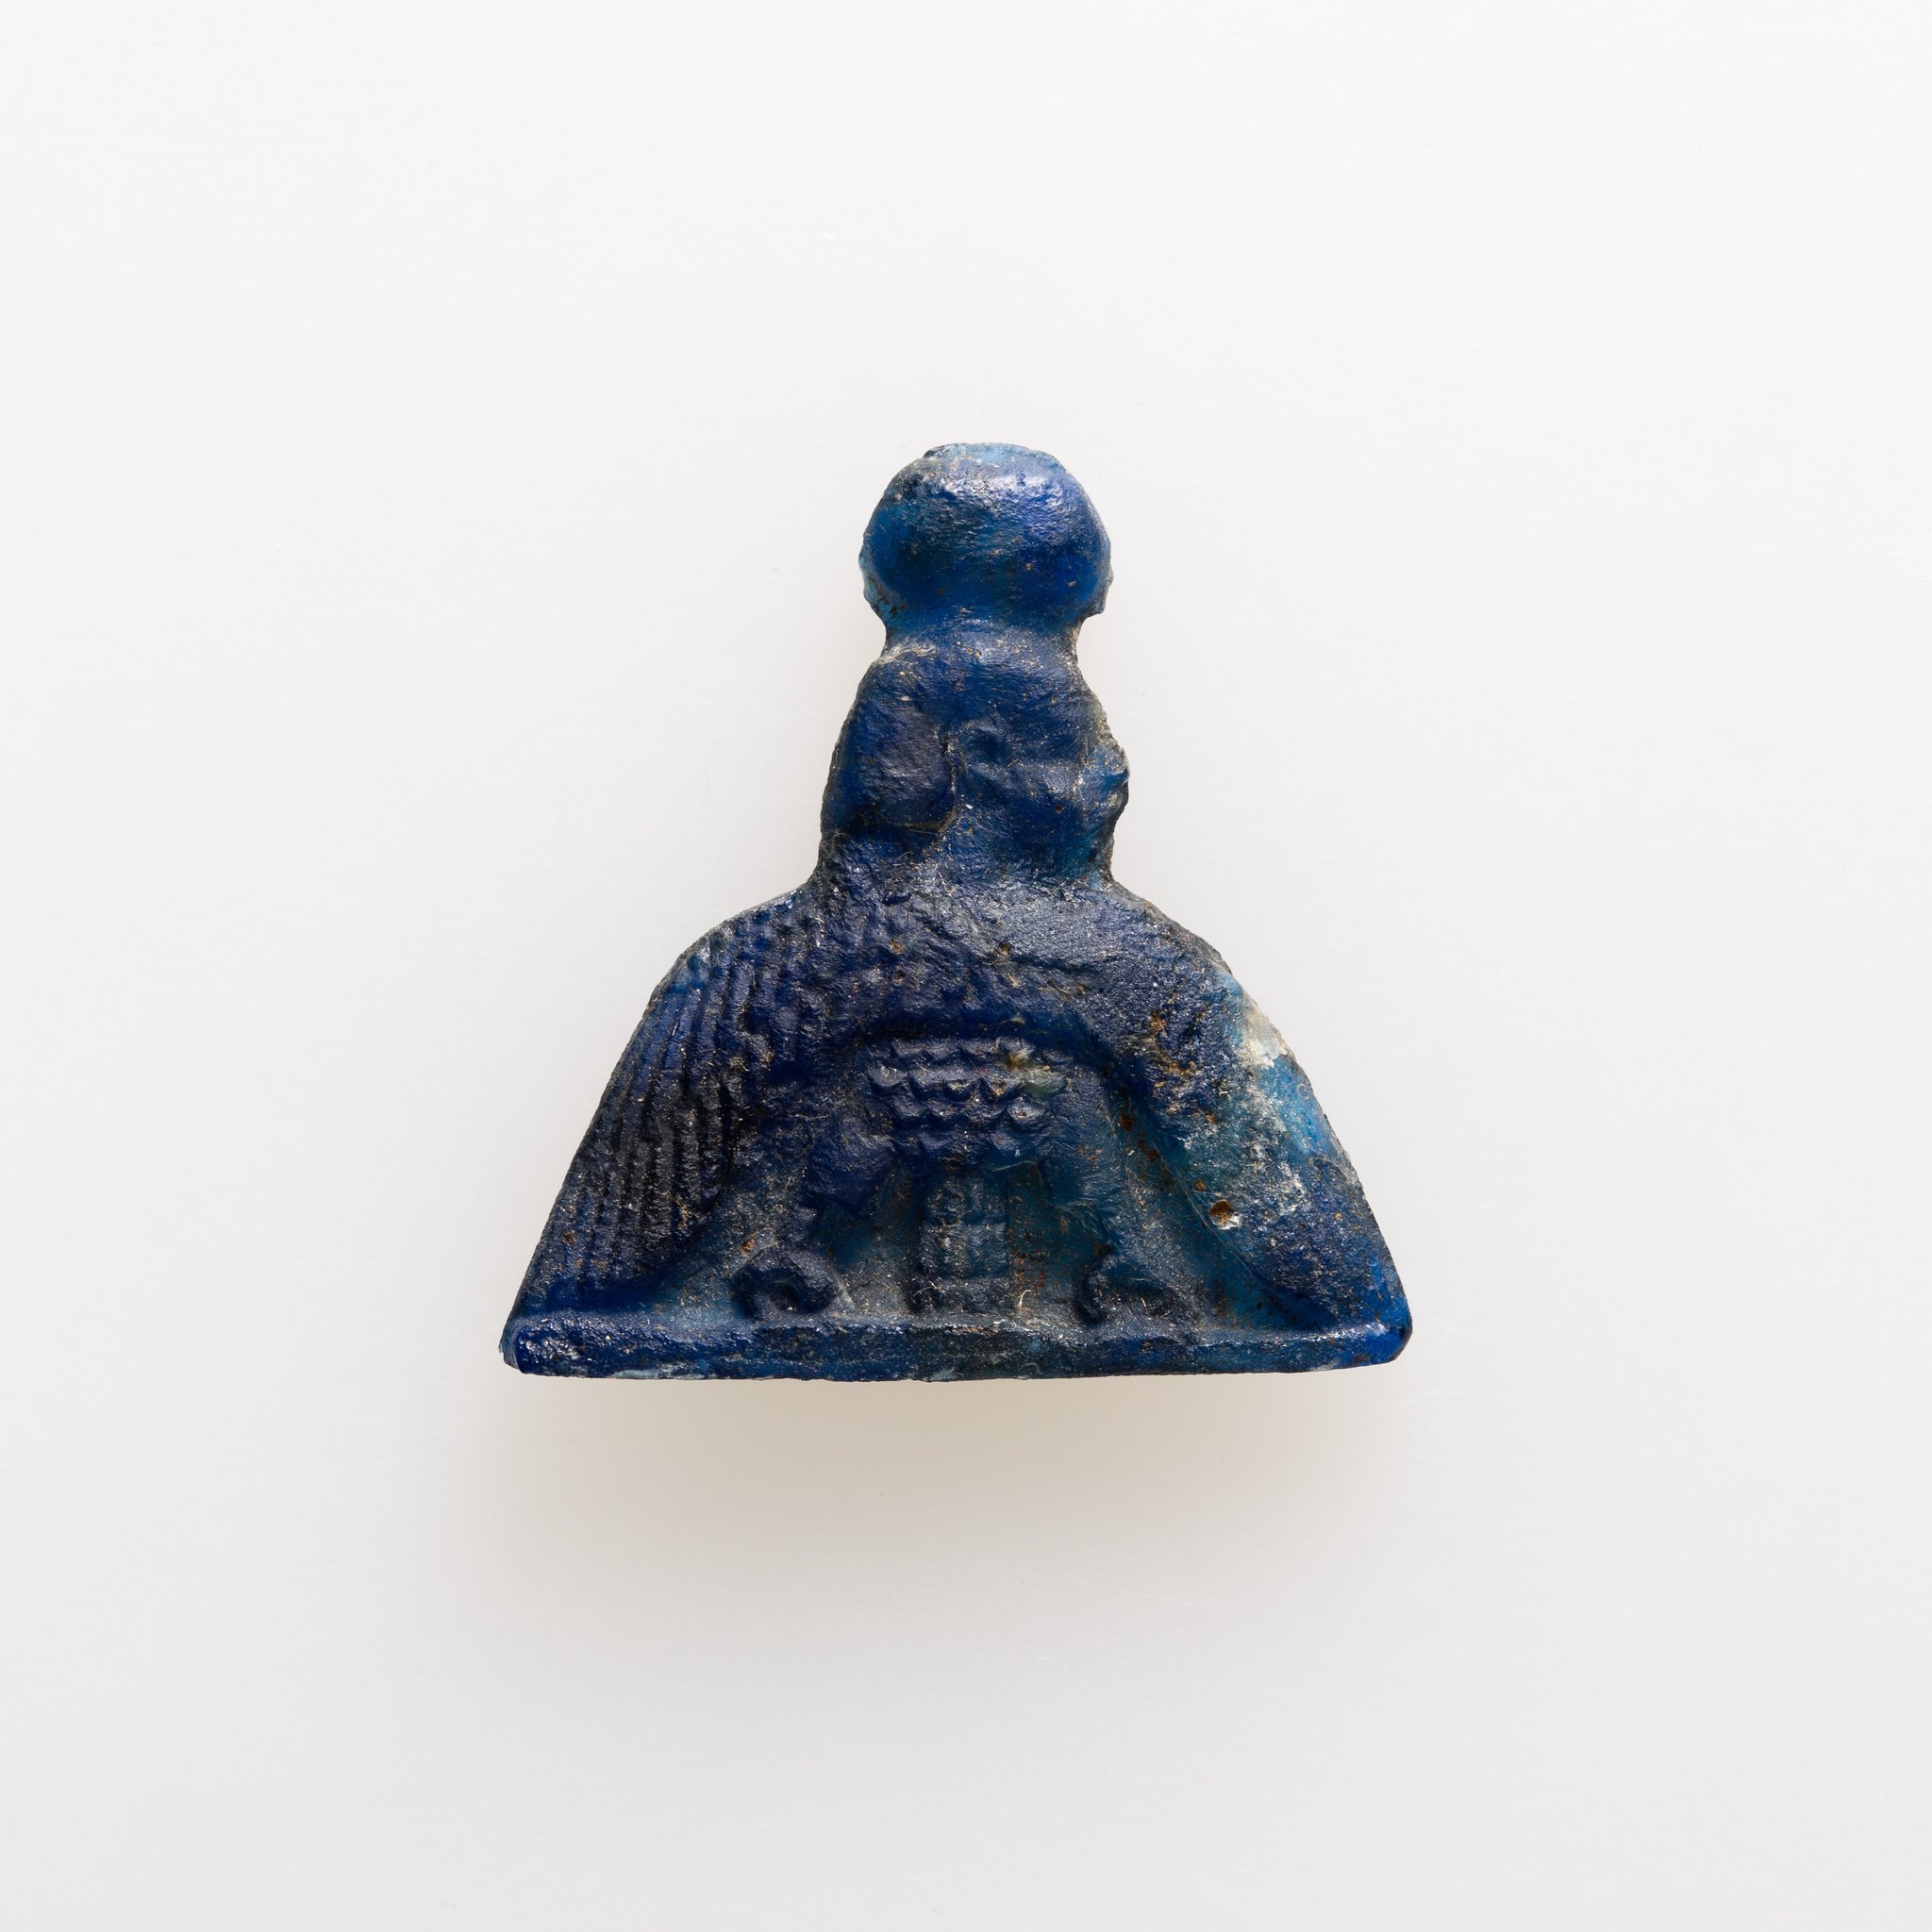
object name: amulet, ba bird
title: Amulet of ba bird wearing a sun disk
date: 525-30 BCE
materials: glass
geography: egypt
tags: birds